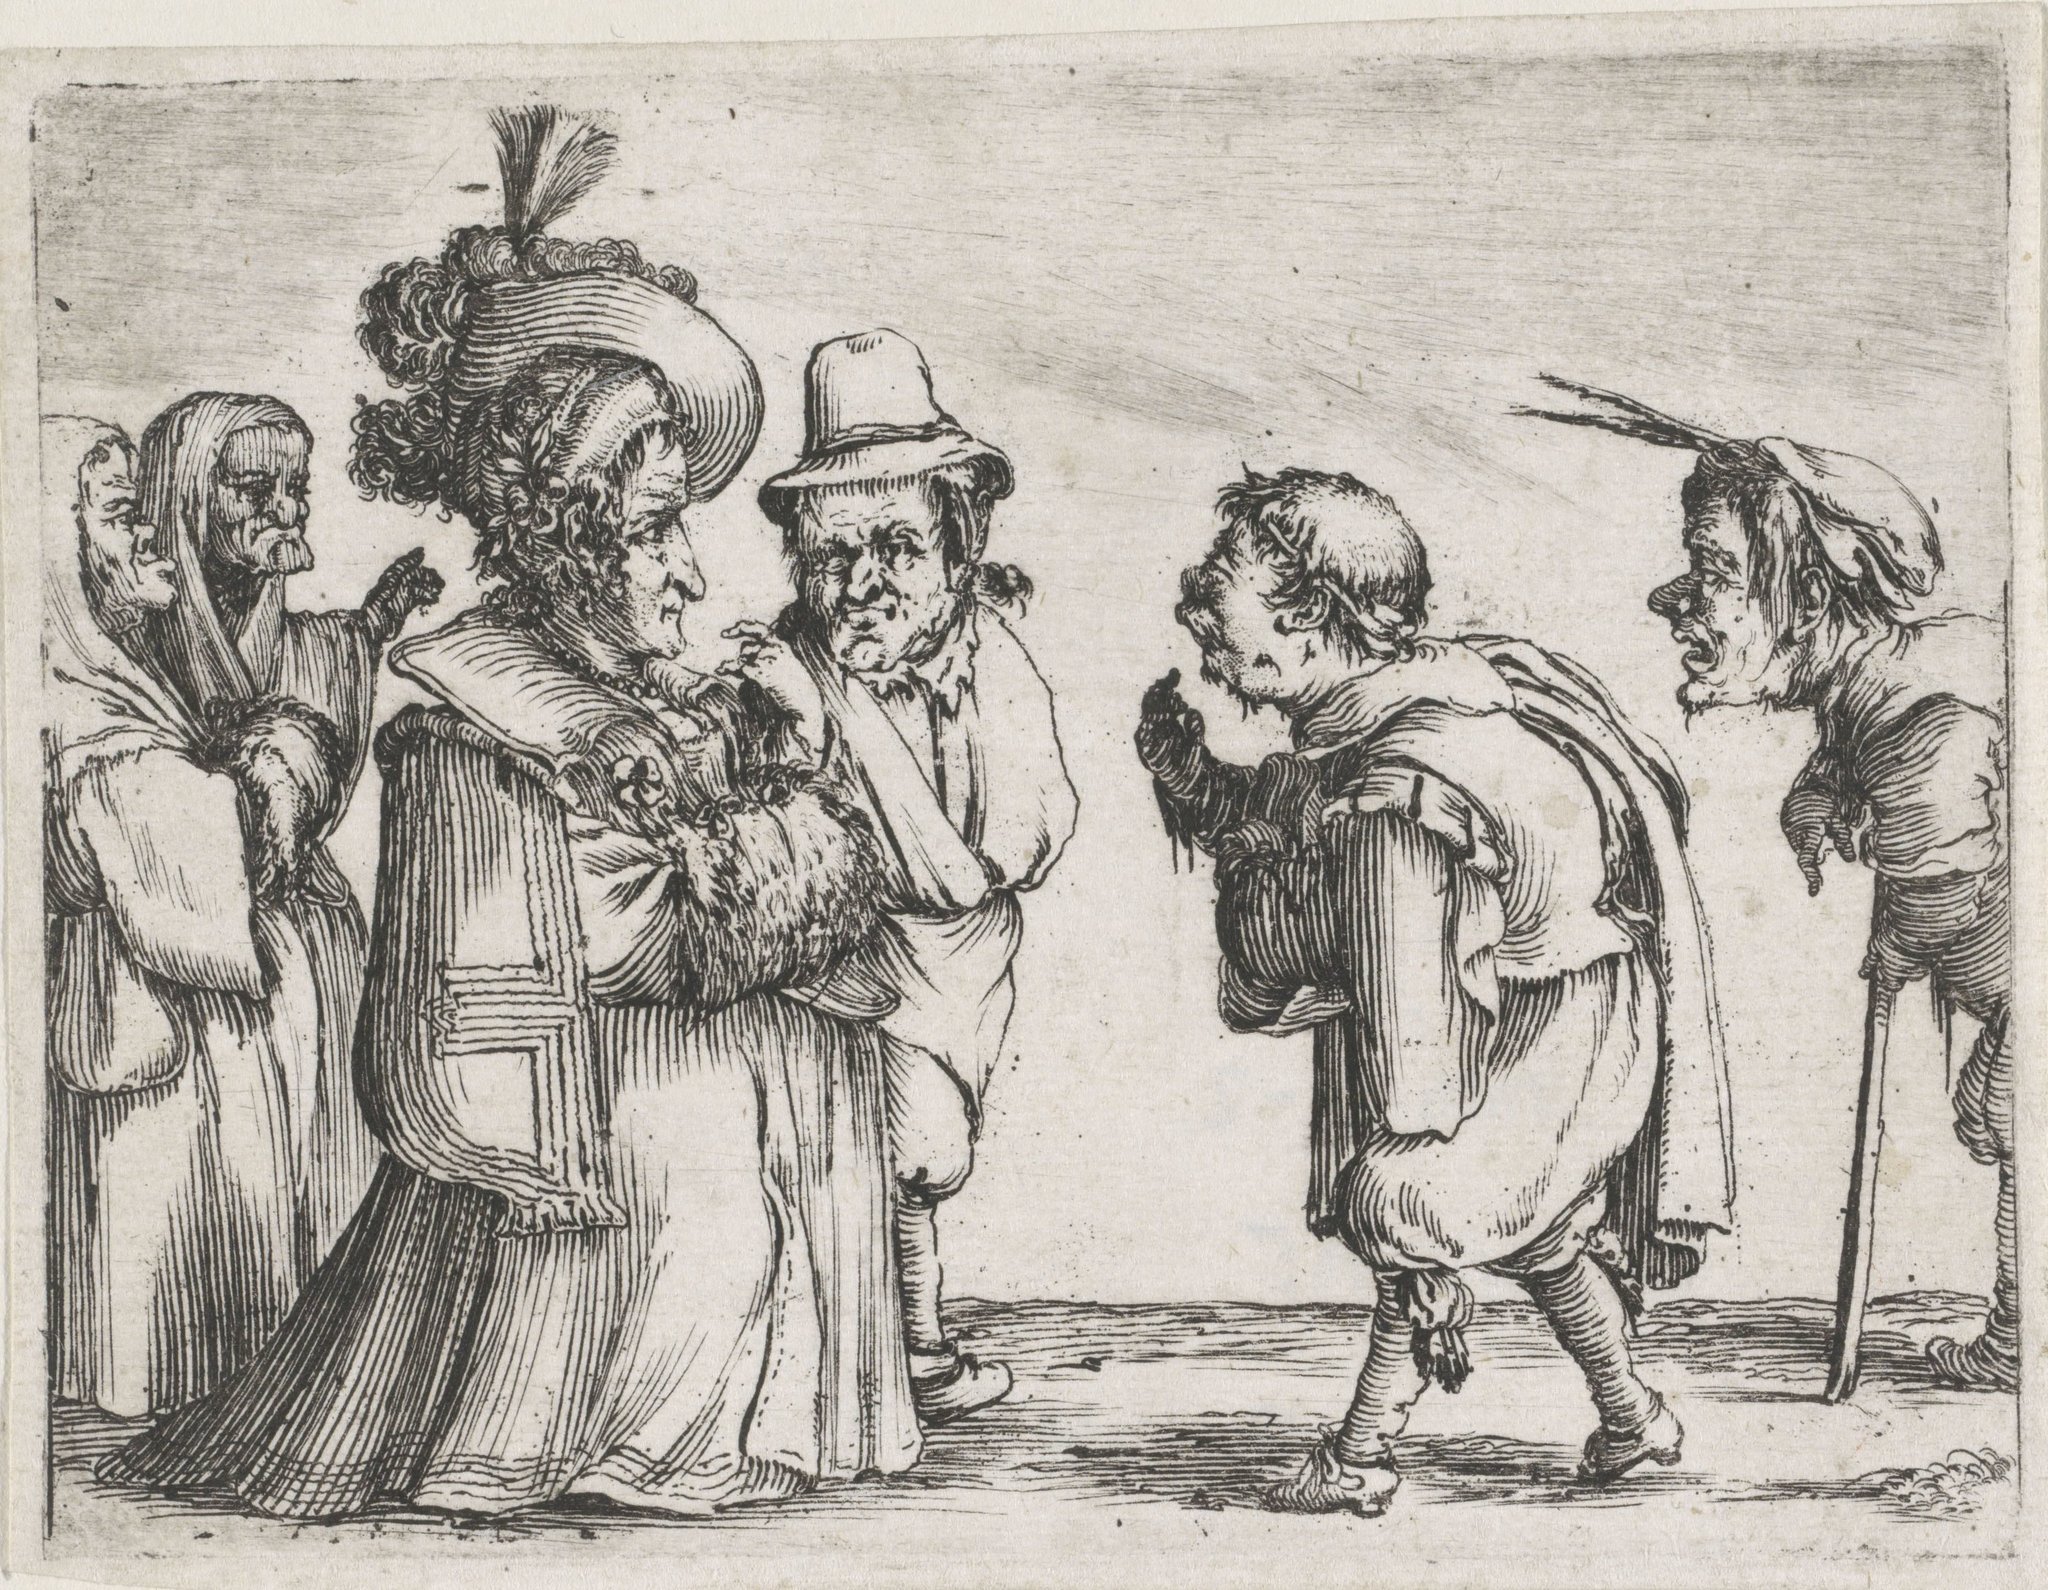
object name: print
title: Komische taferelen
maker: stefano della bella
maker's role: draughtsman, print maker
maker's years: 1610-1664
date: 1620-1664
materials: paper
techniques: etching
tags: little people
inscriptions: collector's mark: Lugt 240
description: Een kleine mens (karikatuur) met gevolg links wordt gegroet door twee kleine mensen (karikaturen) rechts.